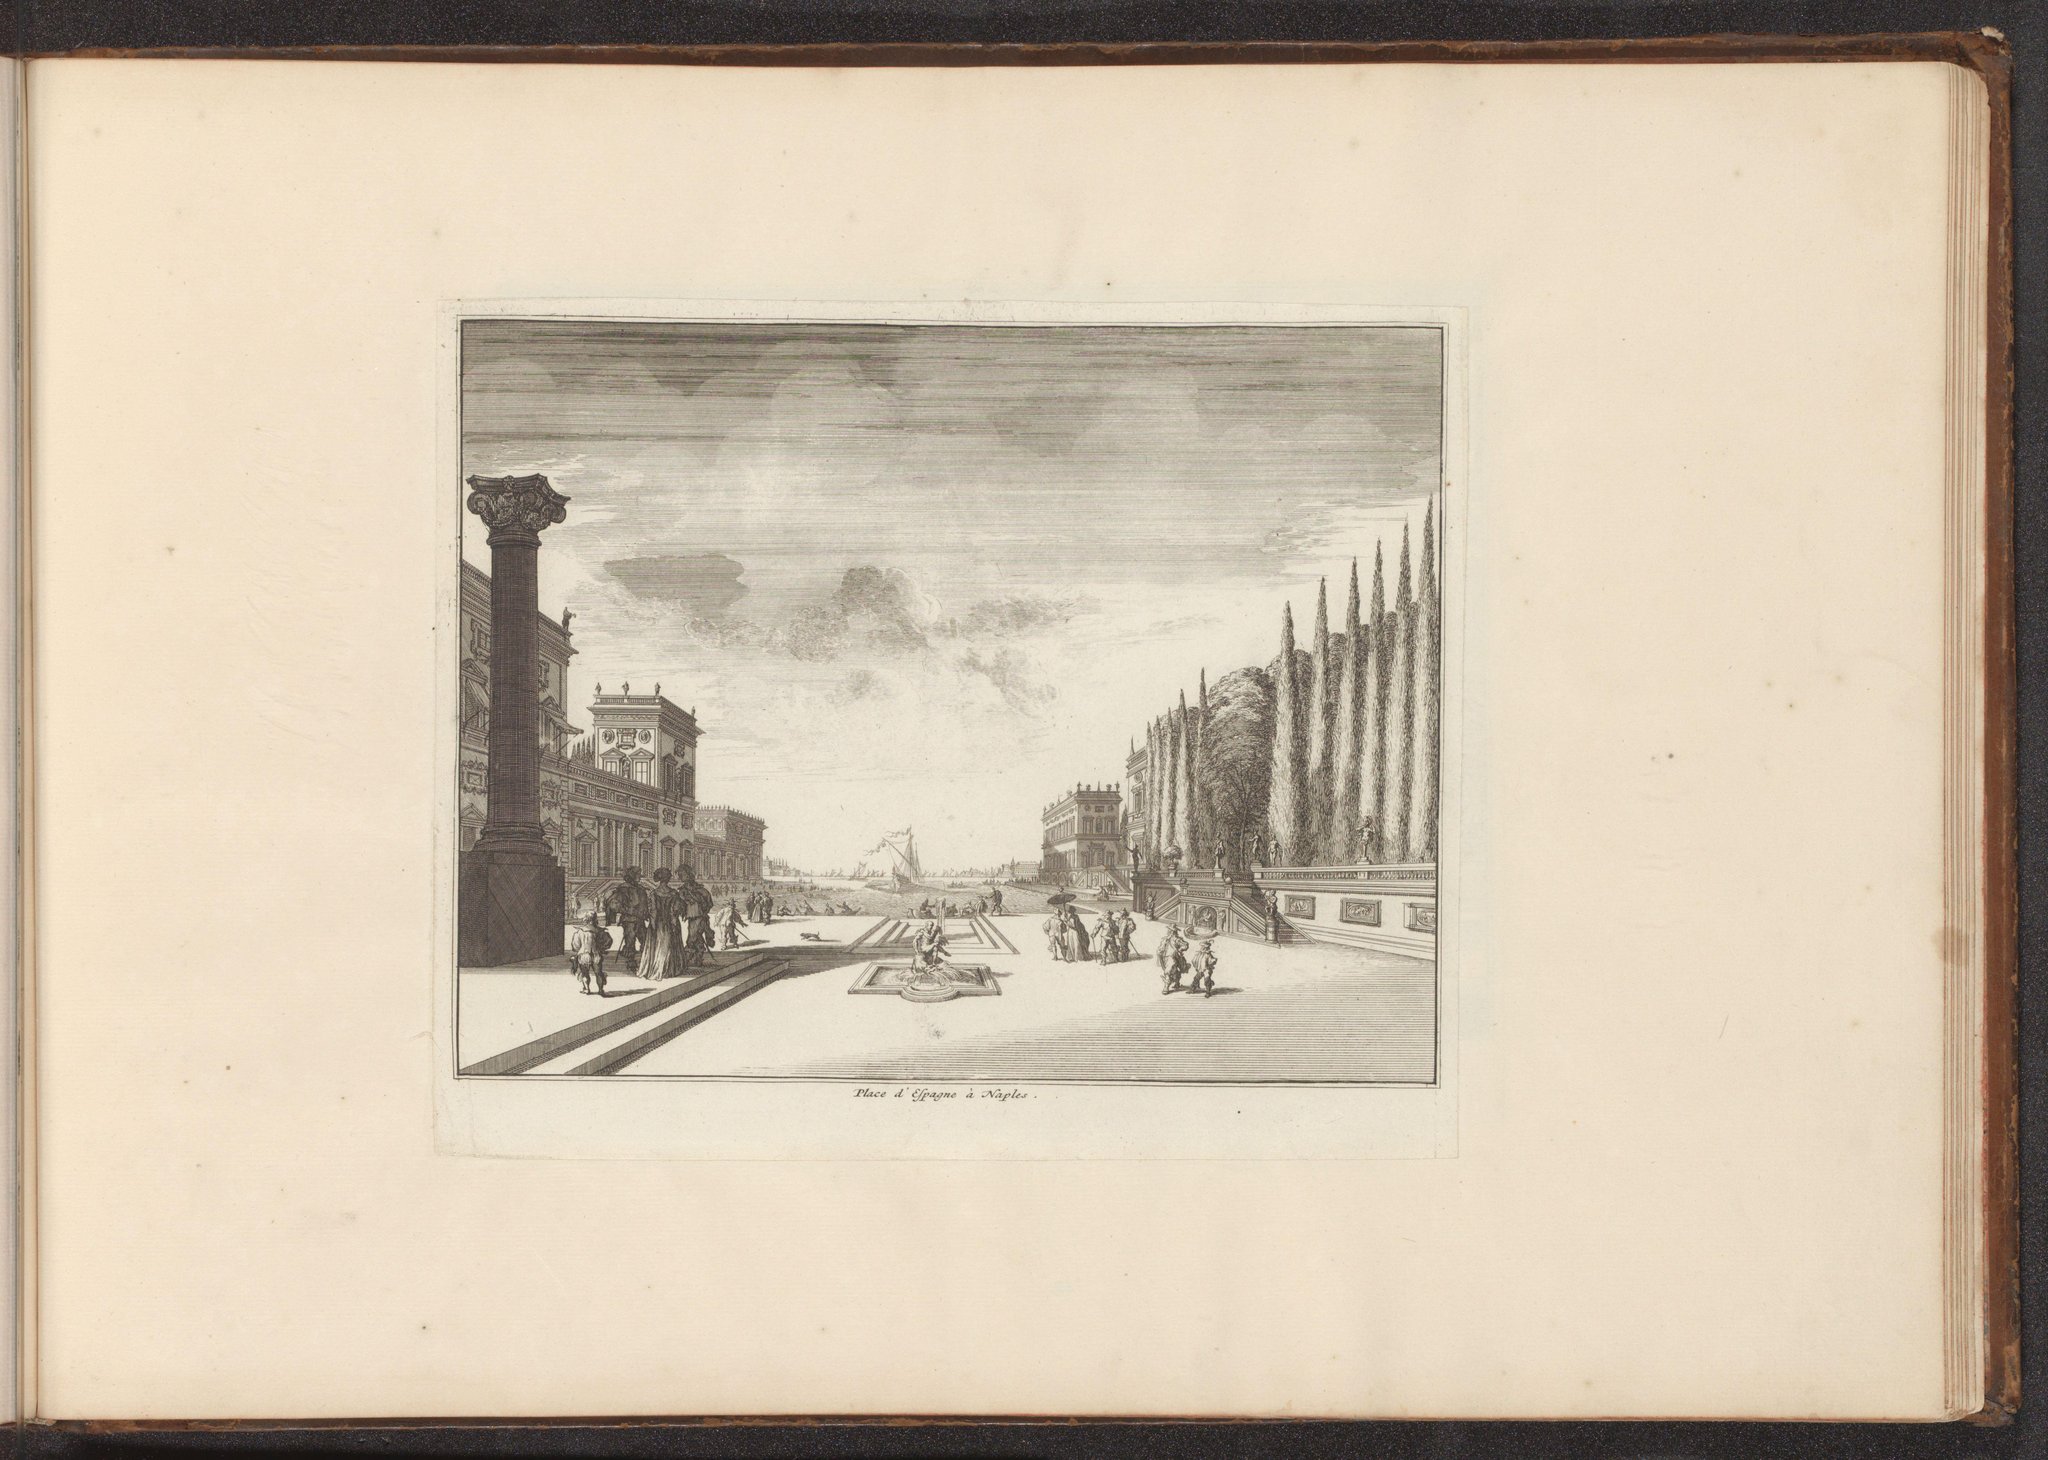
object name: print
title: Place d'Espagna à Naples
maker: Anonymous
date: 1700-1710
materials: paper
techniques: etching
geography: france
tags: square, place, circus, etc., hôtel, i.e. small palace in city, naples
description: Gezicht op Piazza di Spagna te Napels, met links een paleis en rechts tuinen. De prent maakt deel uit van een album.